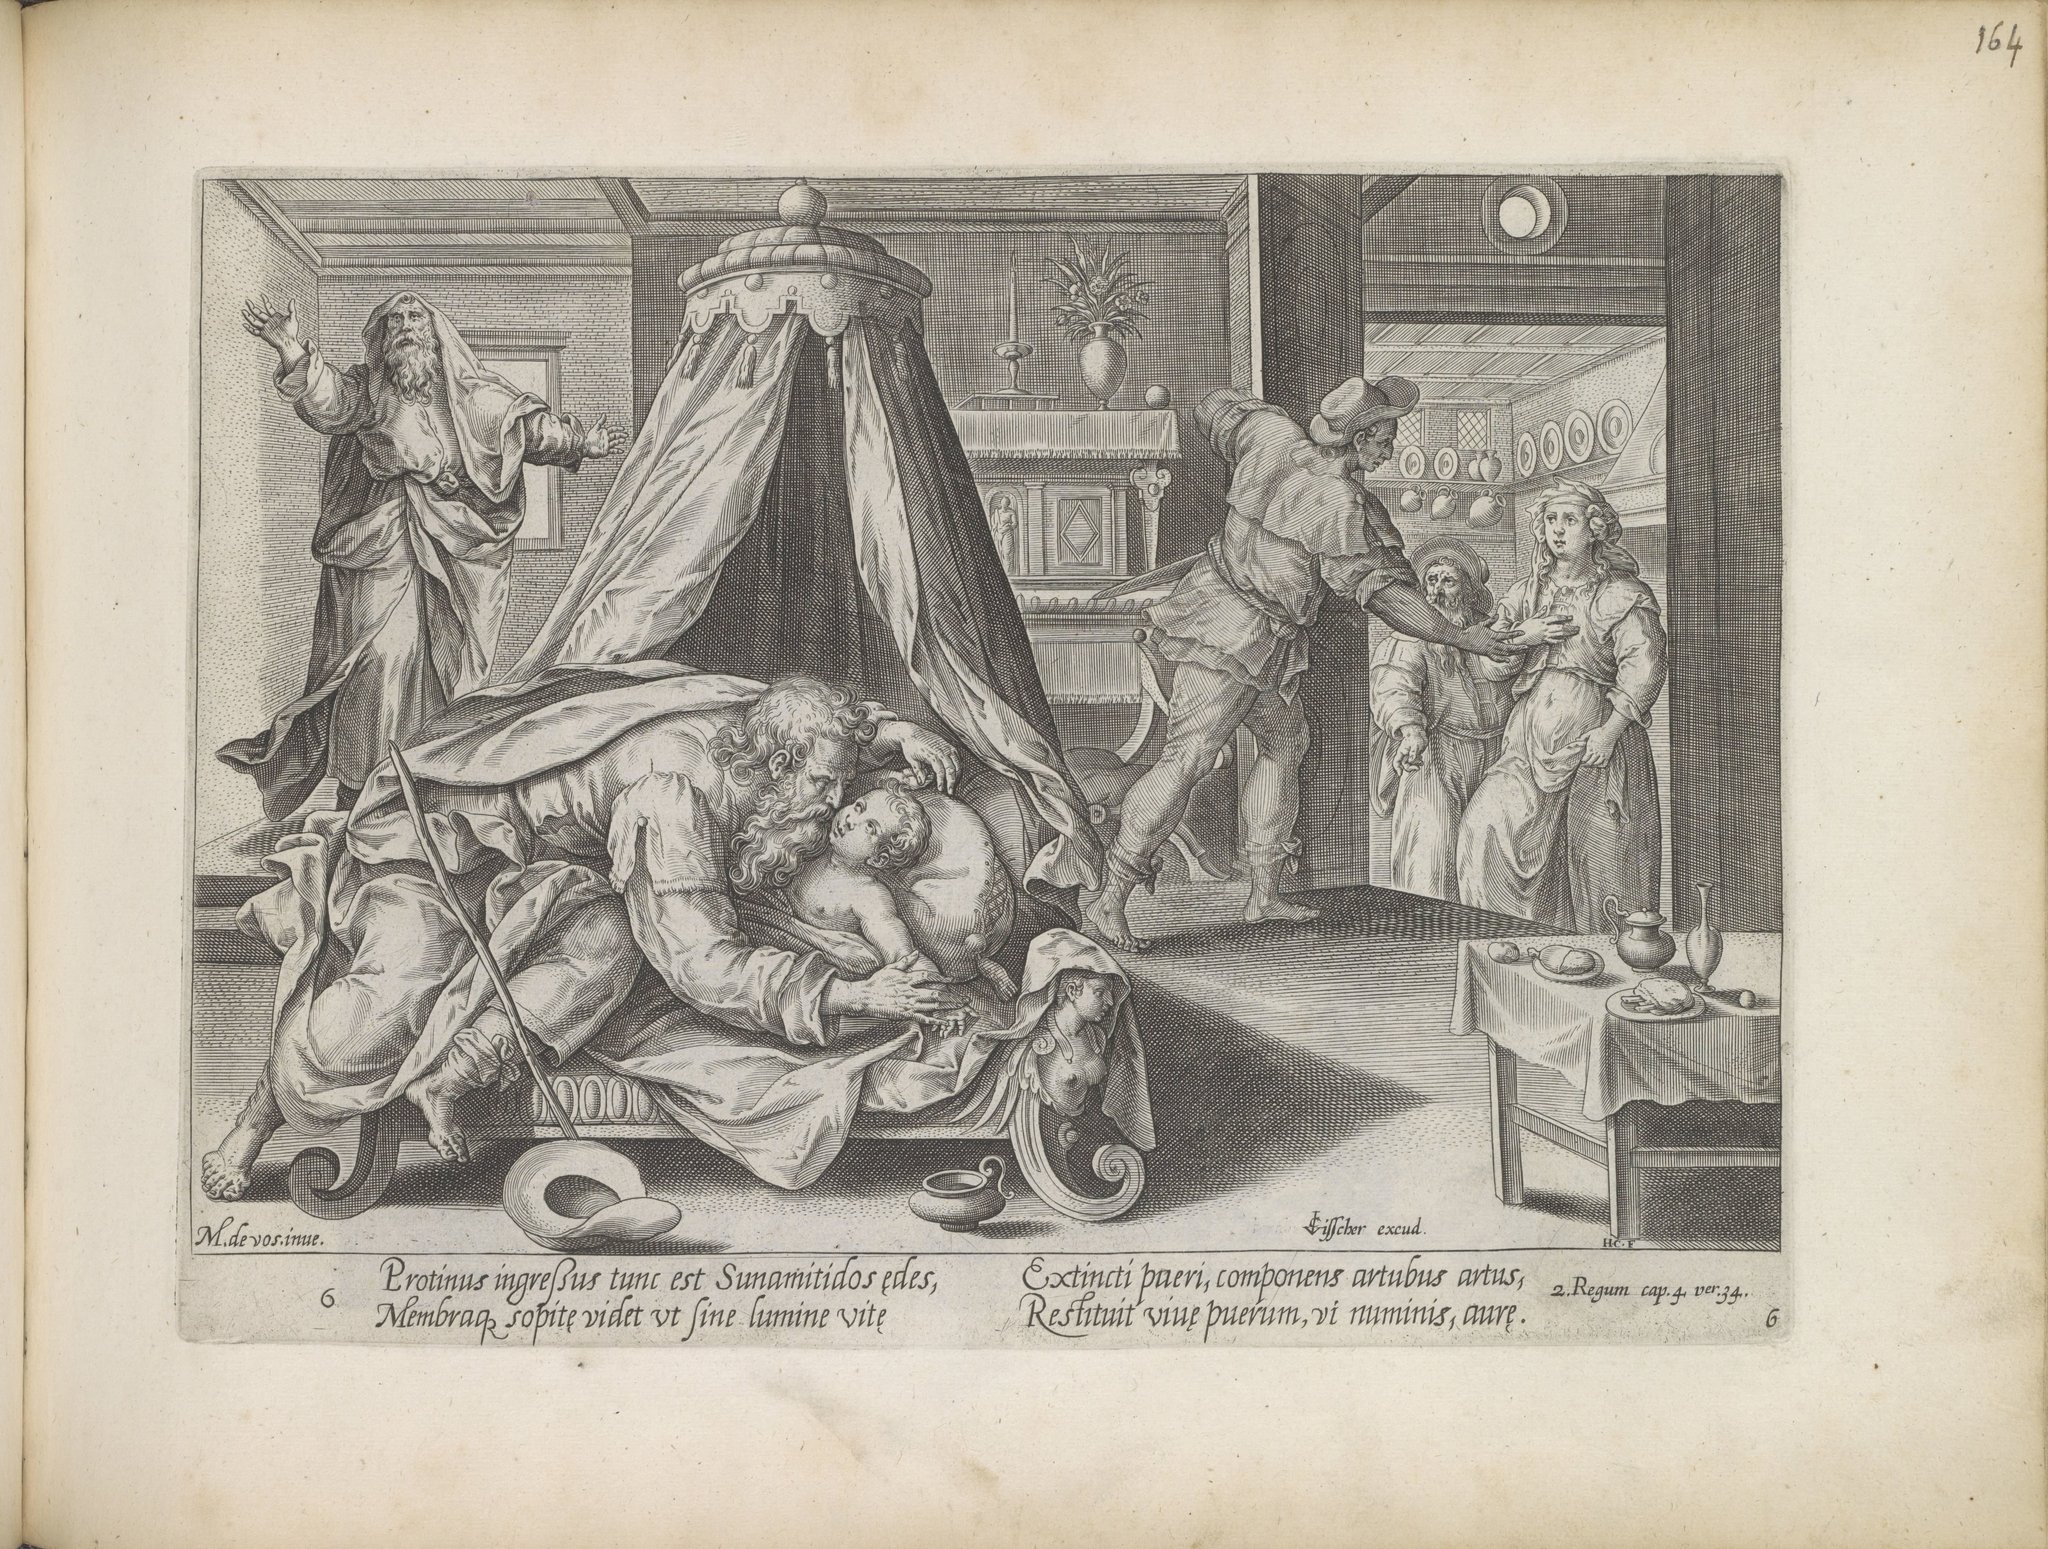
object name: print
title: Geschiedenis van Elisa en de vrouw uit Sunem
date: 1643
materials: paper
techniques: engraving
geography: amsterdam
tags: elisha finds the son of the shunammite woman lying on his bed and prays to god, elisha stretches himself out upon the child of the shunammite woman, raising of the shunammite woman's son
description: Als Elisa is aangekomen sluit Gechazi rechts de deur van het vertrek. De ouders van de gestorven jongen blijven buiten het vertrek. Links bidt Elisa met geheven armen tot God. In het midden strekt hij zich uit over de gestoven jongen met zijn mond op zijn mond en zijn handpalmen op de handpalmen van de jongen. Zo wekt Elisa de jongen tot leven. Onder de voorstelling een verwijzing in het Latijn naar de Bijbeltekst in 2 Kon. 4:34. Deze prent maakt deel uit van een album.